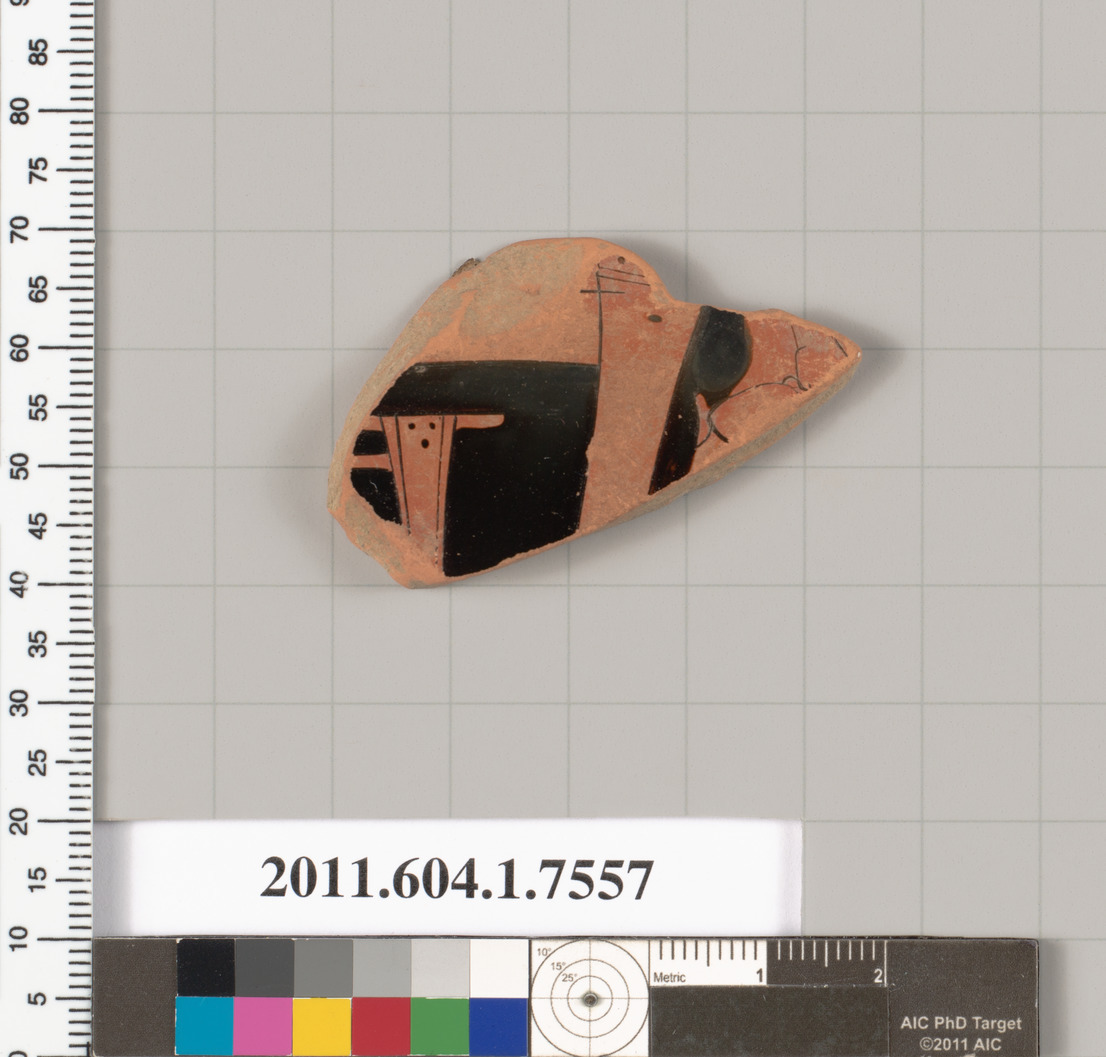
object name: kylix fragment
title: Terracotta fragment of a kylix (drinking cup)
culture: greek, attic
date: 460-450 BCE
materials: terracotta